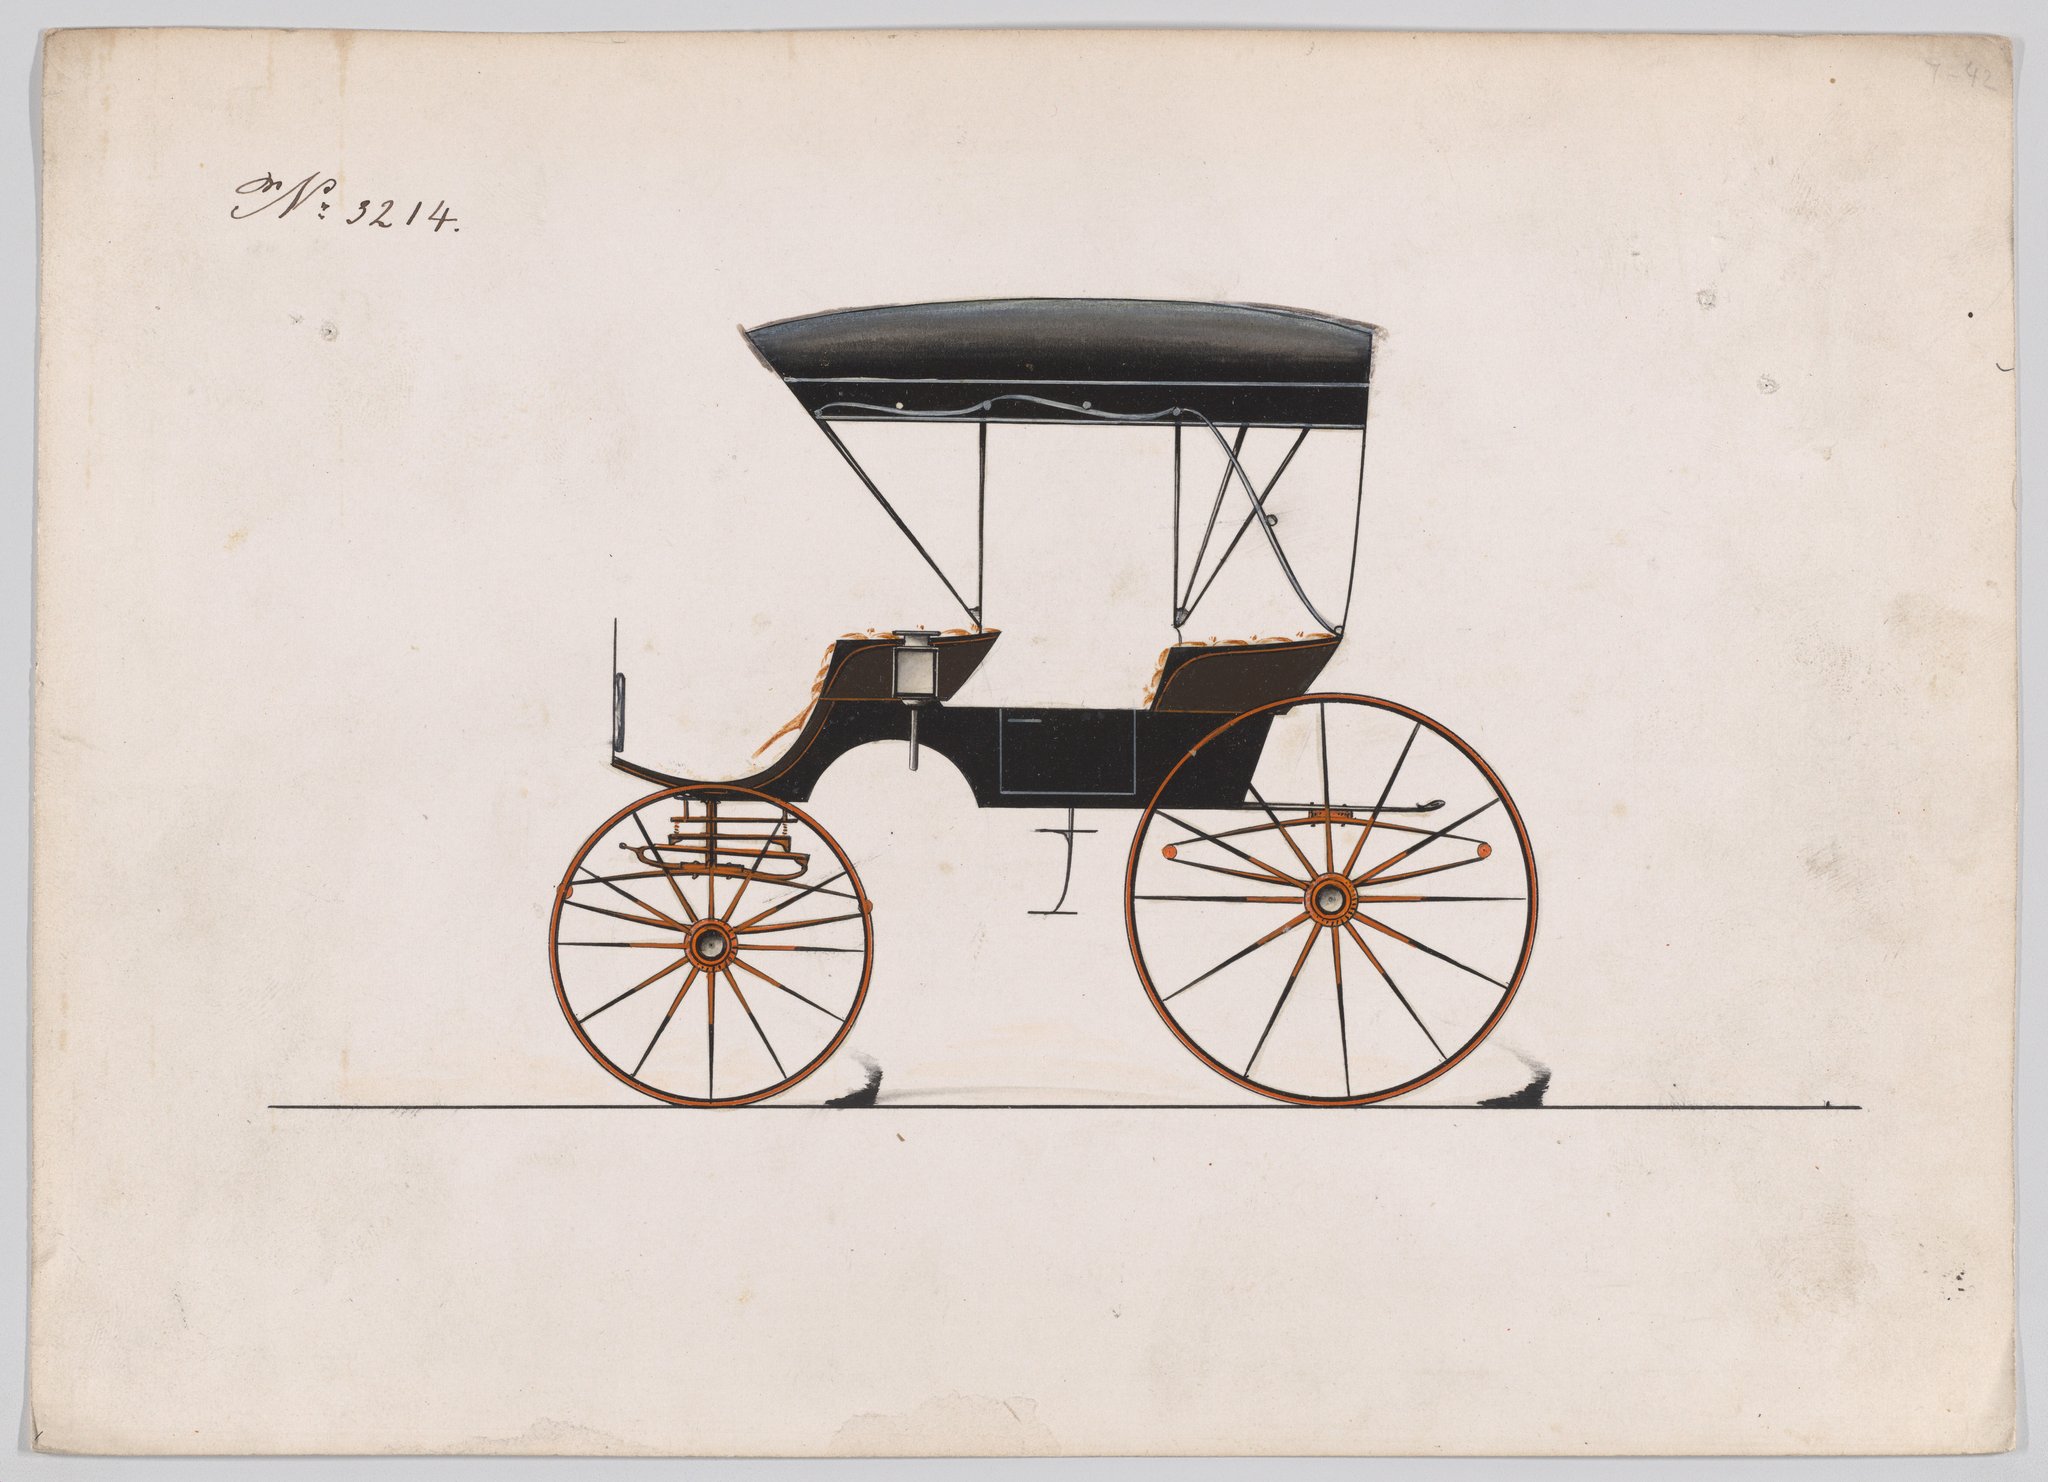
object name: drawing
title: Design for Park Phaeton, no. 3214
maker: brewster & co.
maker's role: manufacturer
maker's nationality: american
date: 1876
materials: gouache, gum arabic, ink, watercolor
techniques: pen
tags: carriages